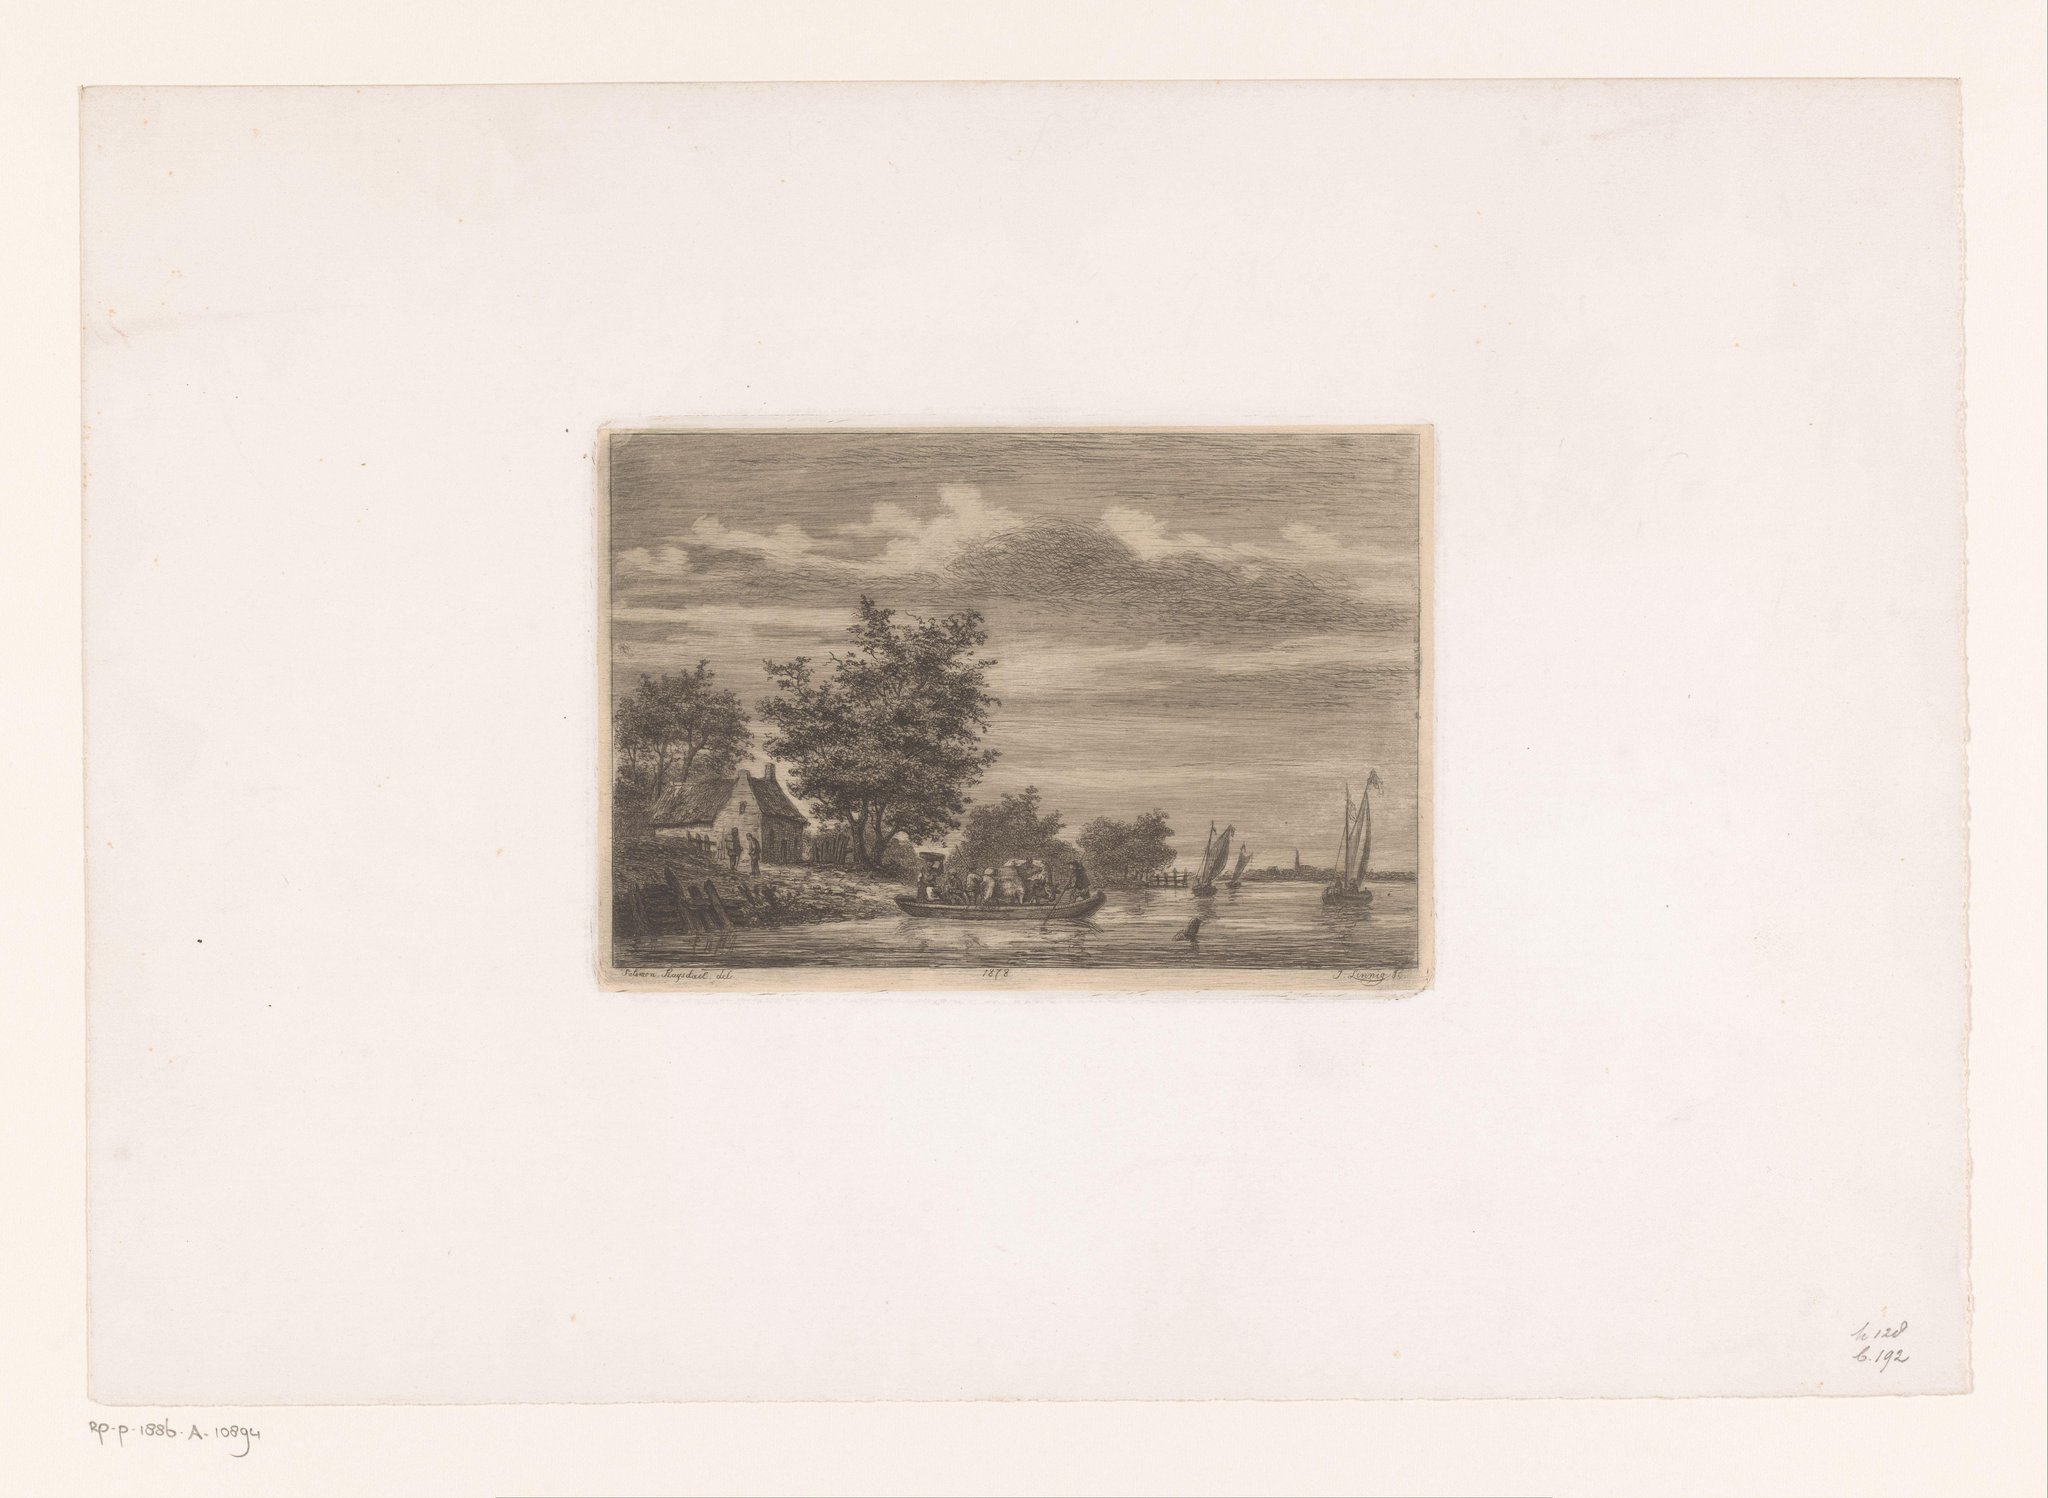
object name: print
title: Riviergezicht met een veerpont die personen en koeien oversteekt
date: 1878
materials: paper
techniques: etching, intaglio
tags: sailing-ship, sailing-boat, ferry, poling, punting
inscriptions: collector's mark: Lugt 2228